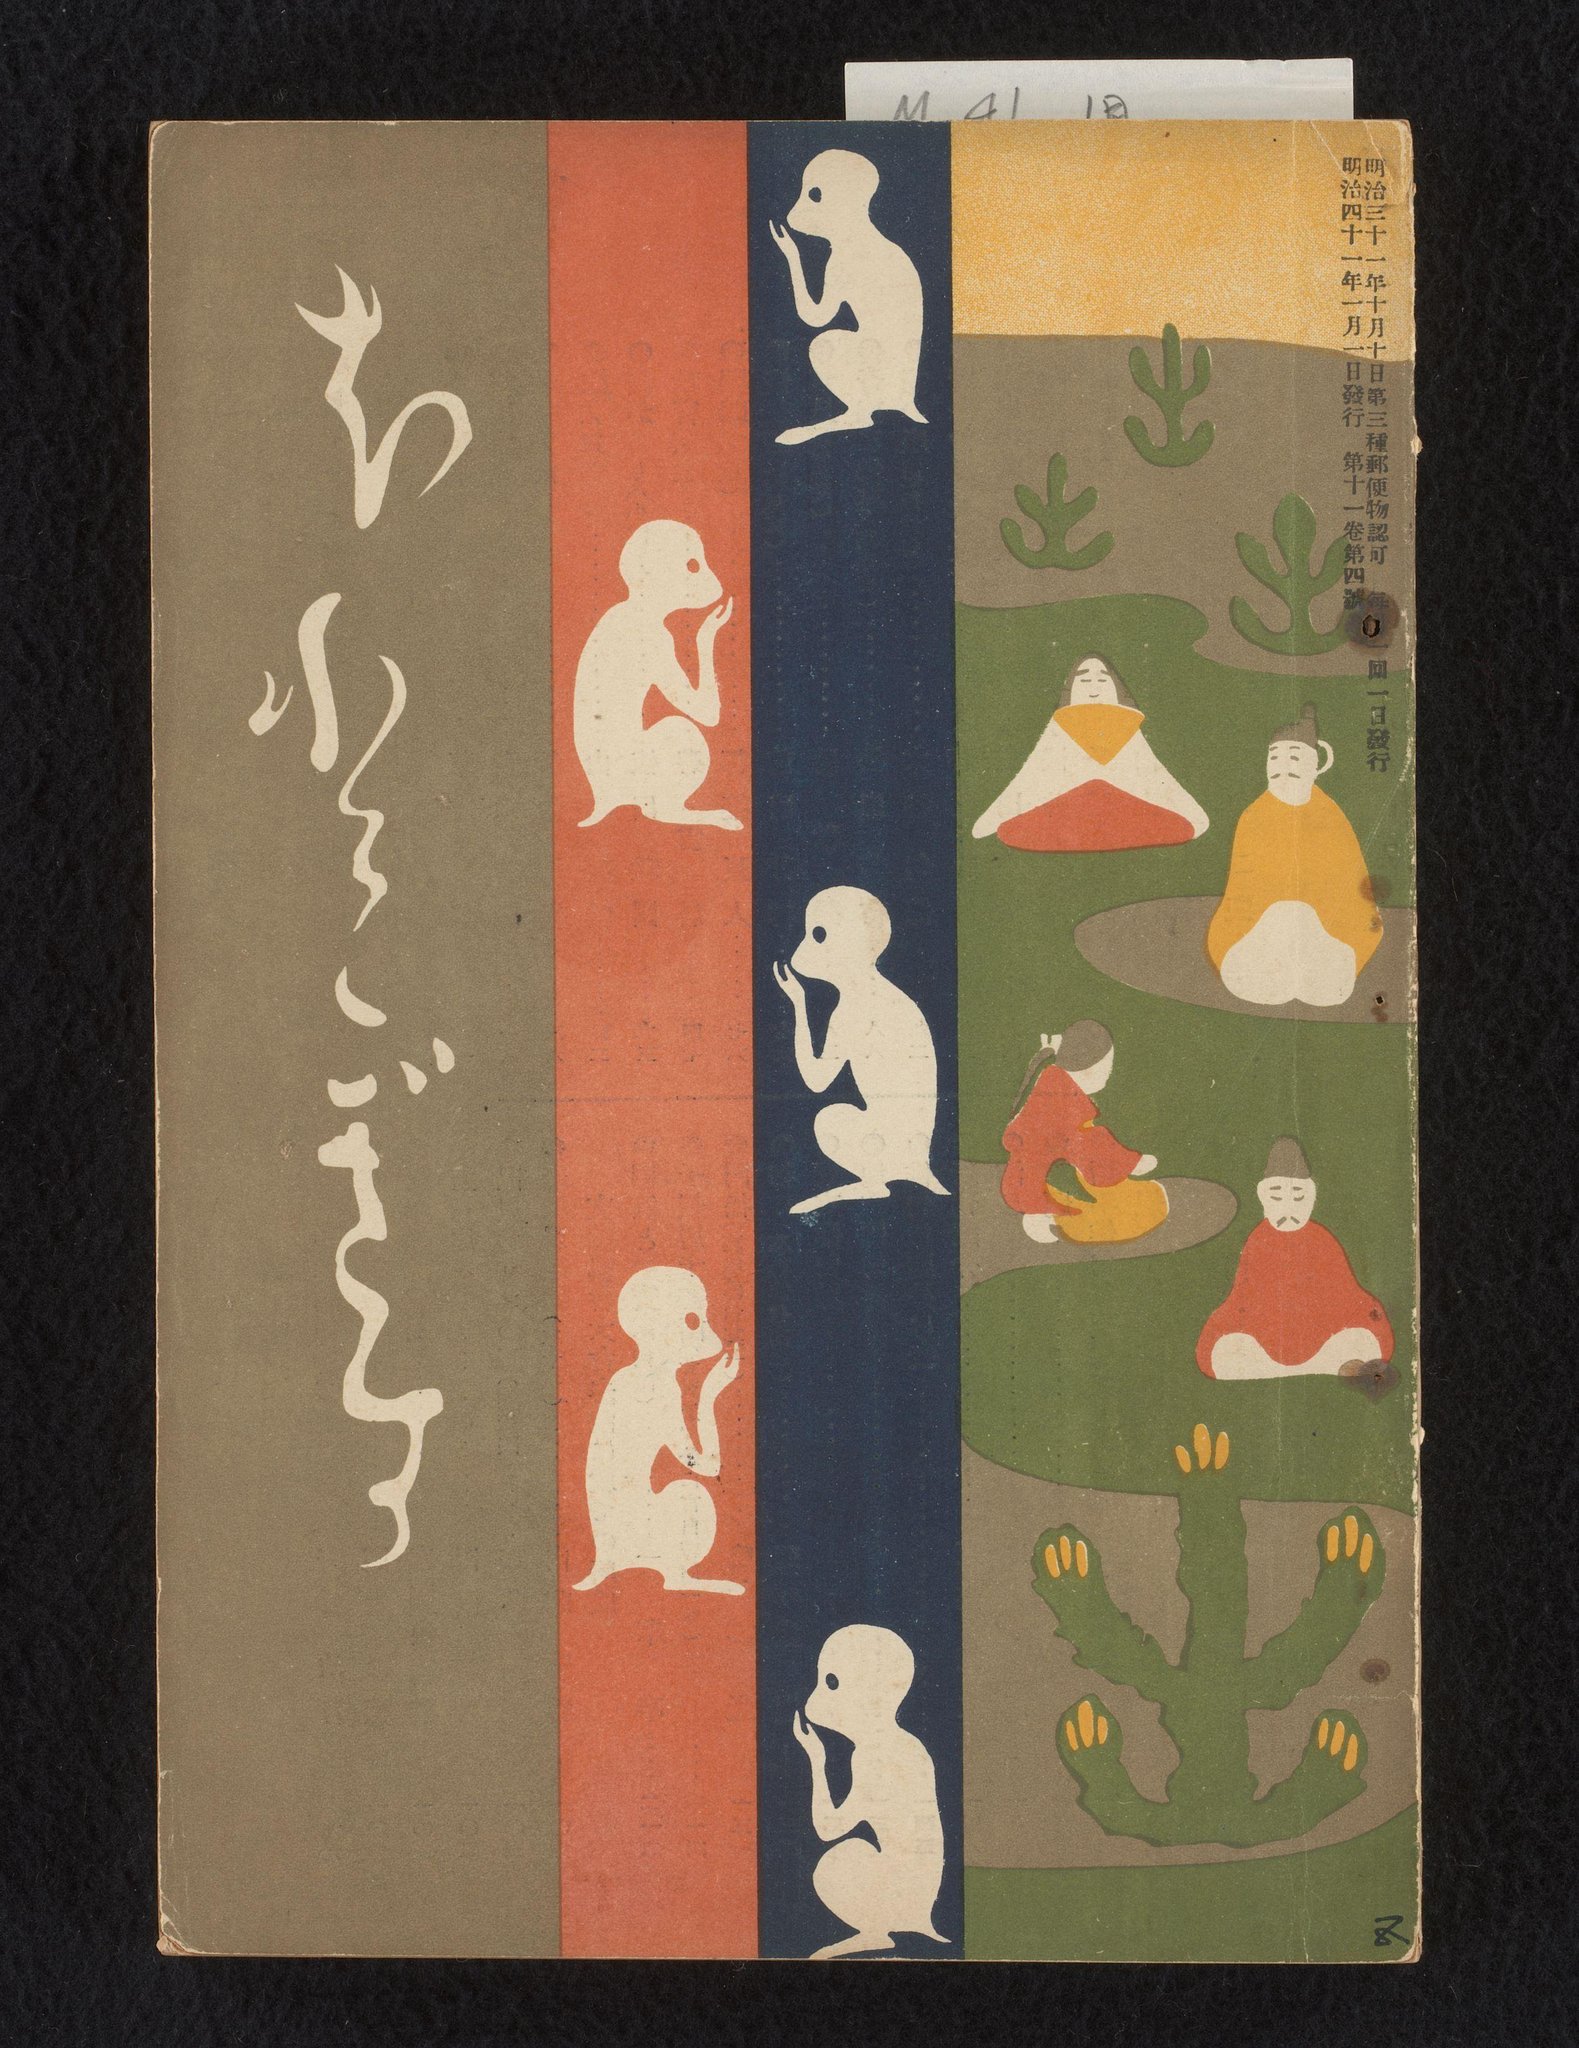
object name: magazine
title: Hototogisu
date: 1908-1909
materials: paper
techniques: woodcut, letterpress printing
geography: japan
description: Zeven uitgaven uit de jaren 1908-1909 van het literaire maandblad Hototogisu, waar veel verschillende schrijvers en kunstenaars aan hebben meegewerkt.